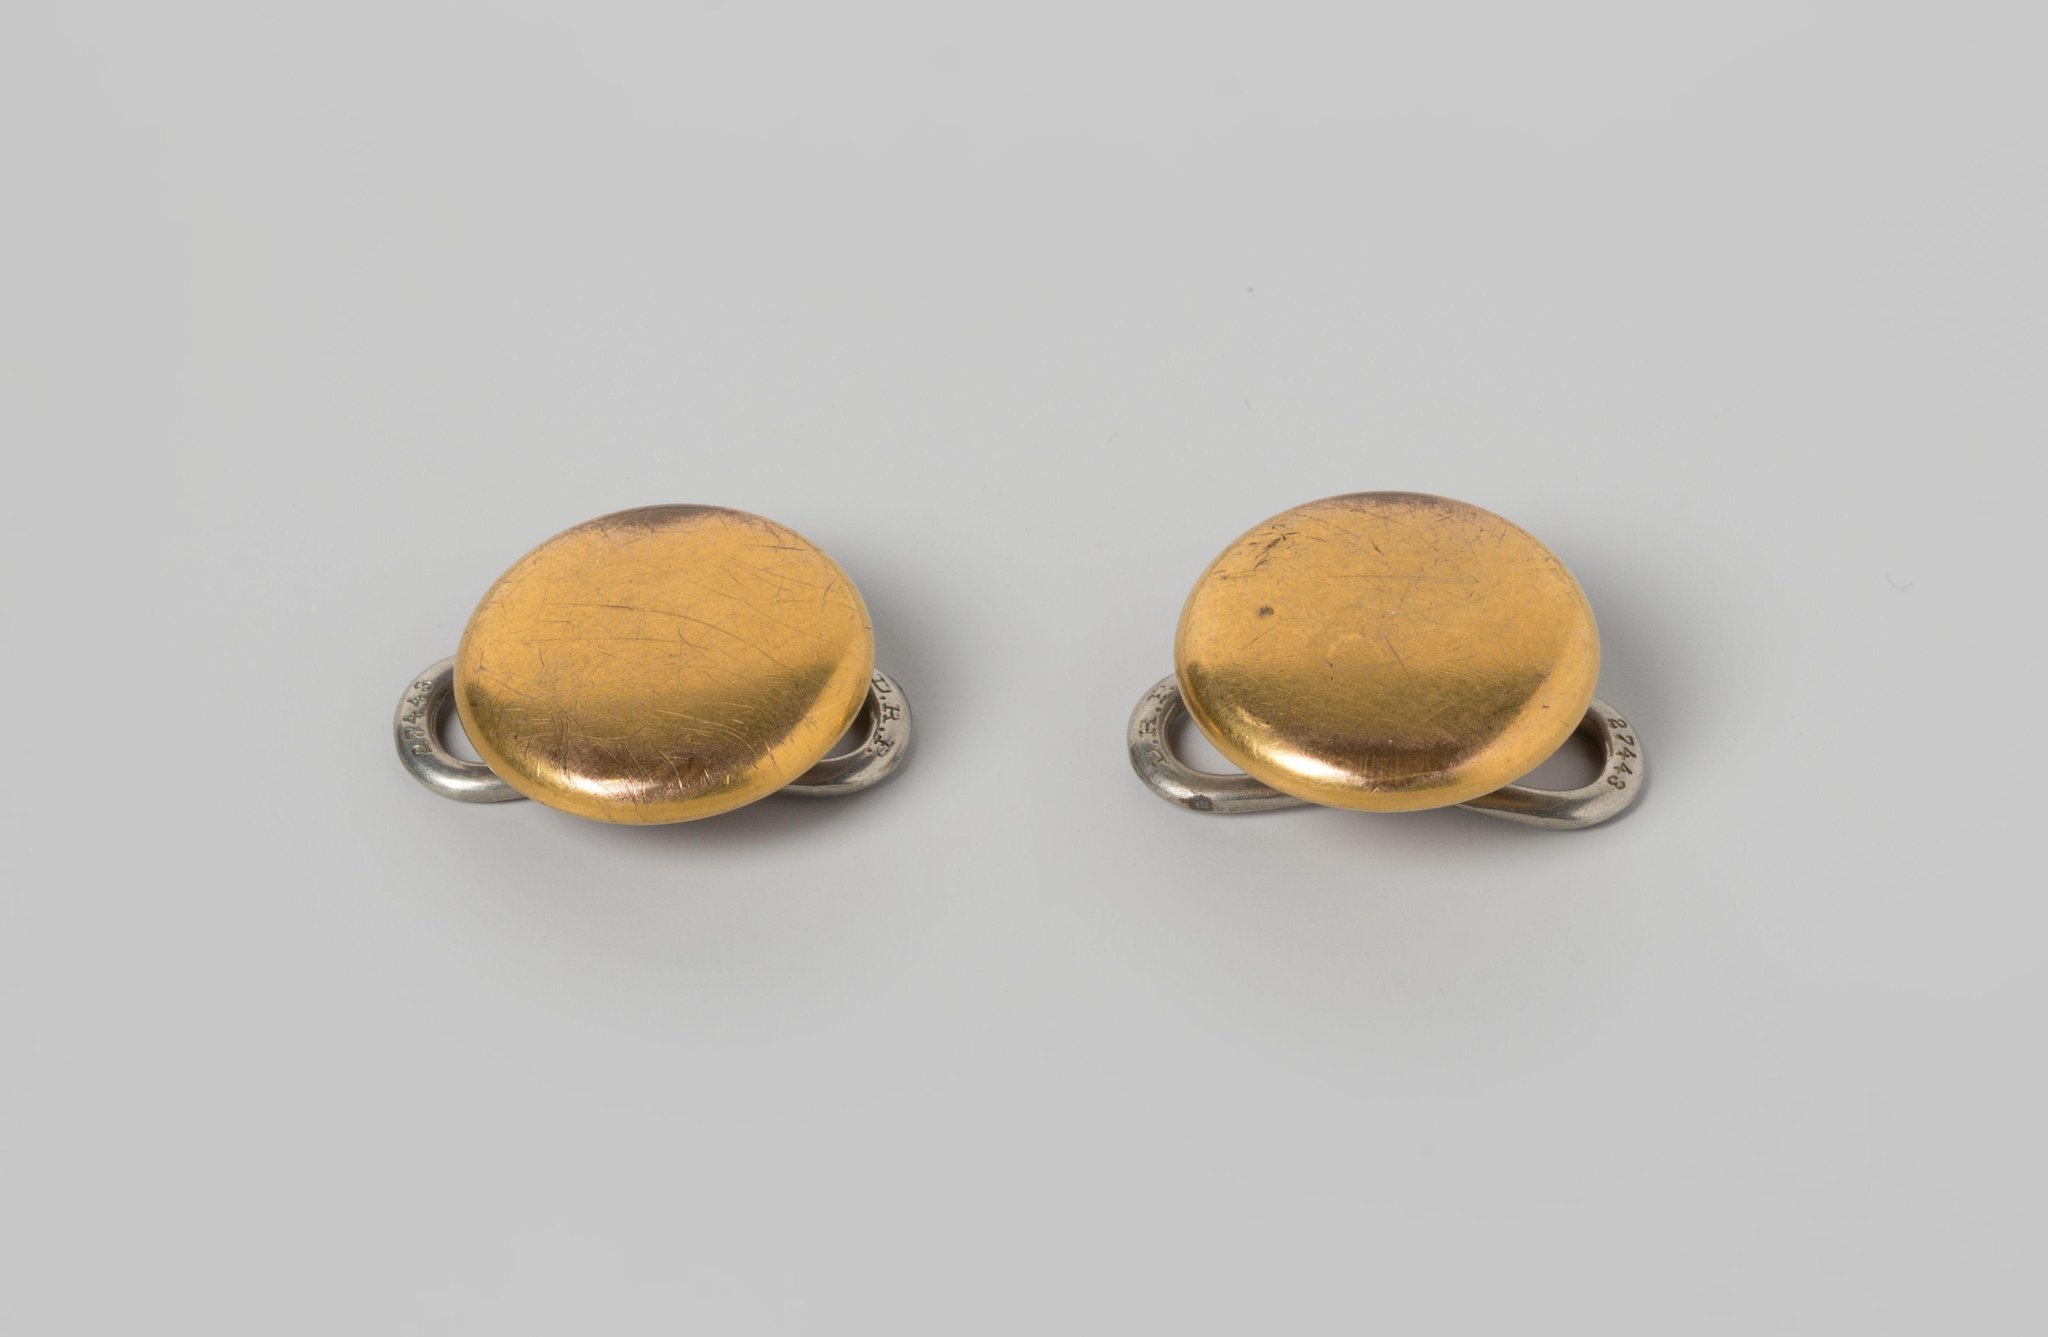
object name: menswear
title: Vestknoop van metaal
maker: Anonymous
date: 1900-1940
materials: metal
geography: netherlands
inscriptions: mark: ‘D.R.F. (?) en 27443’